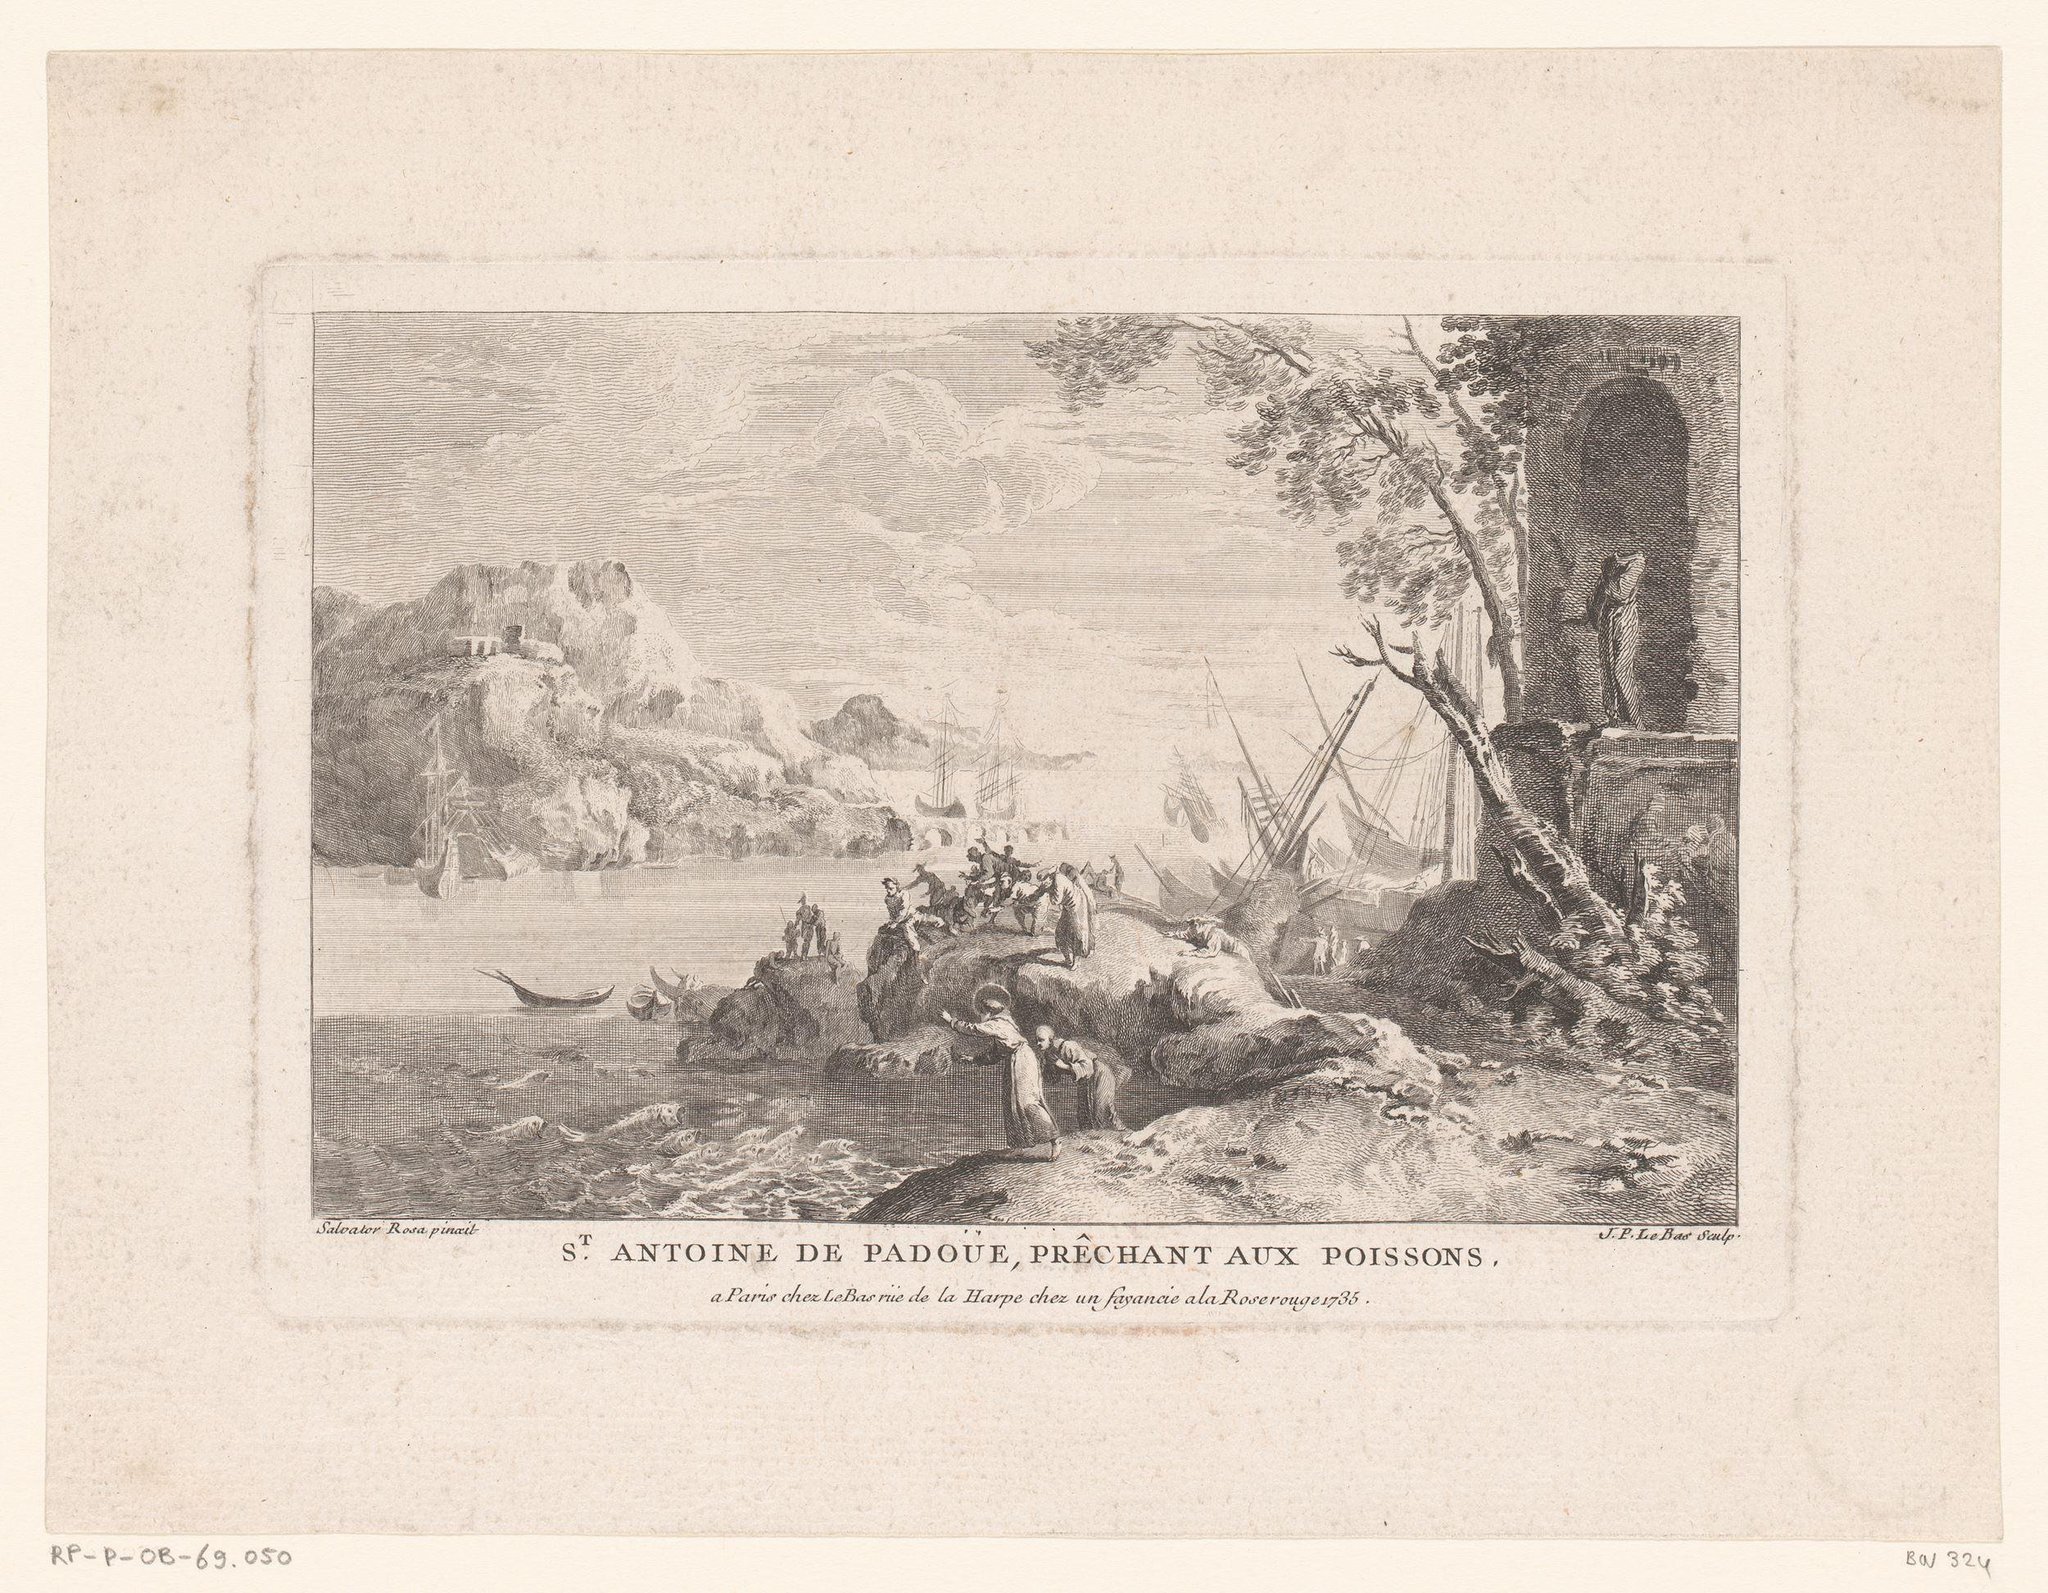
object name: print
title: Antonius van Padua predikt tot de vissen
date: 1735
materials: paper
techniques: engraving, etching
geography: paris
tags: 11h(antony of padua)54 of padua preaching on the sea-shore; the fishes pressing forward to hear him, their heads out of the water, the franciscan monk antony of padua; possible attributes: ass, book, crucifix, flowered cross, flaming heart, infant christ (on book), lily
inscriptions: collector's mark: Lugt 240